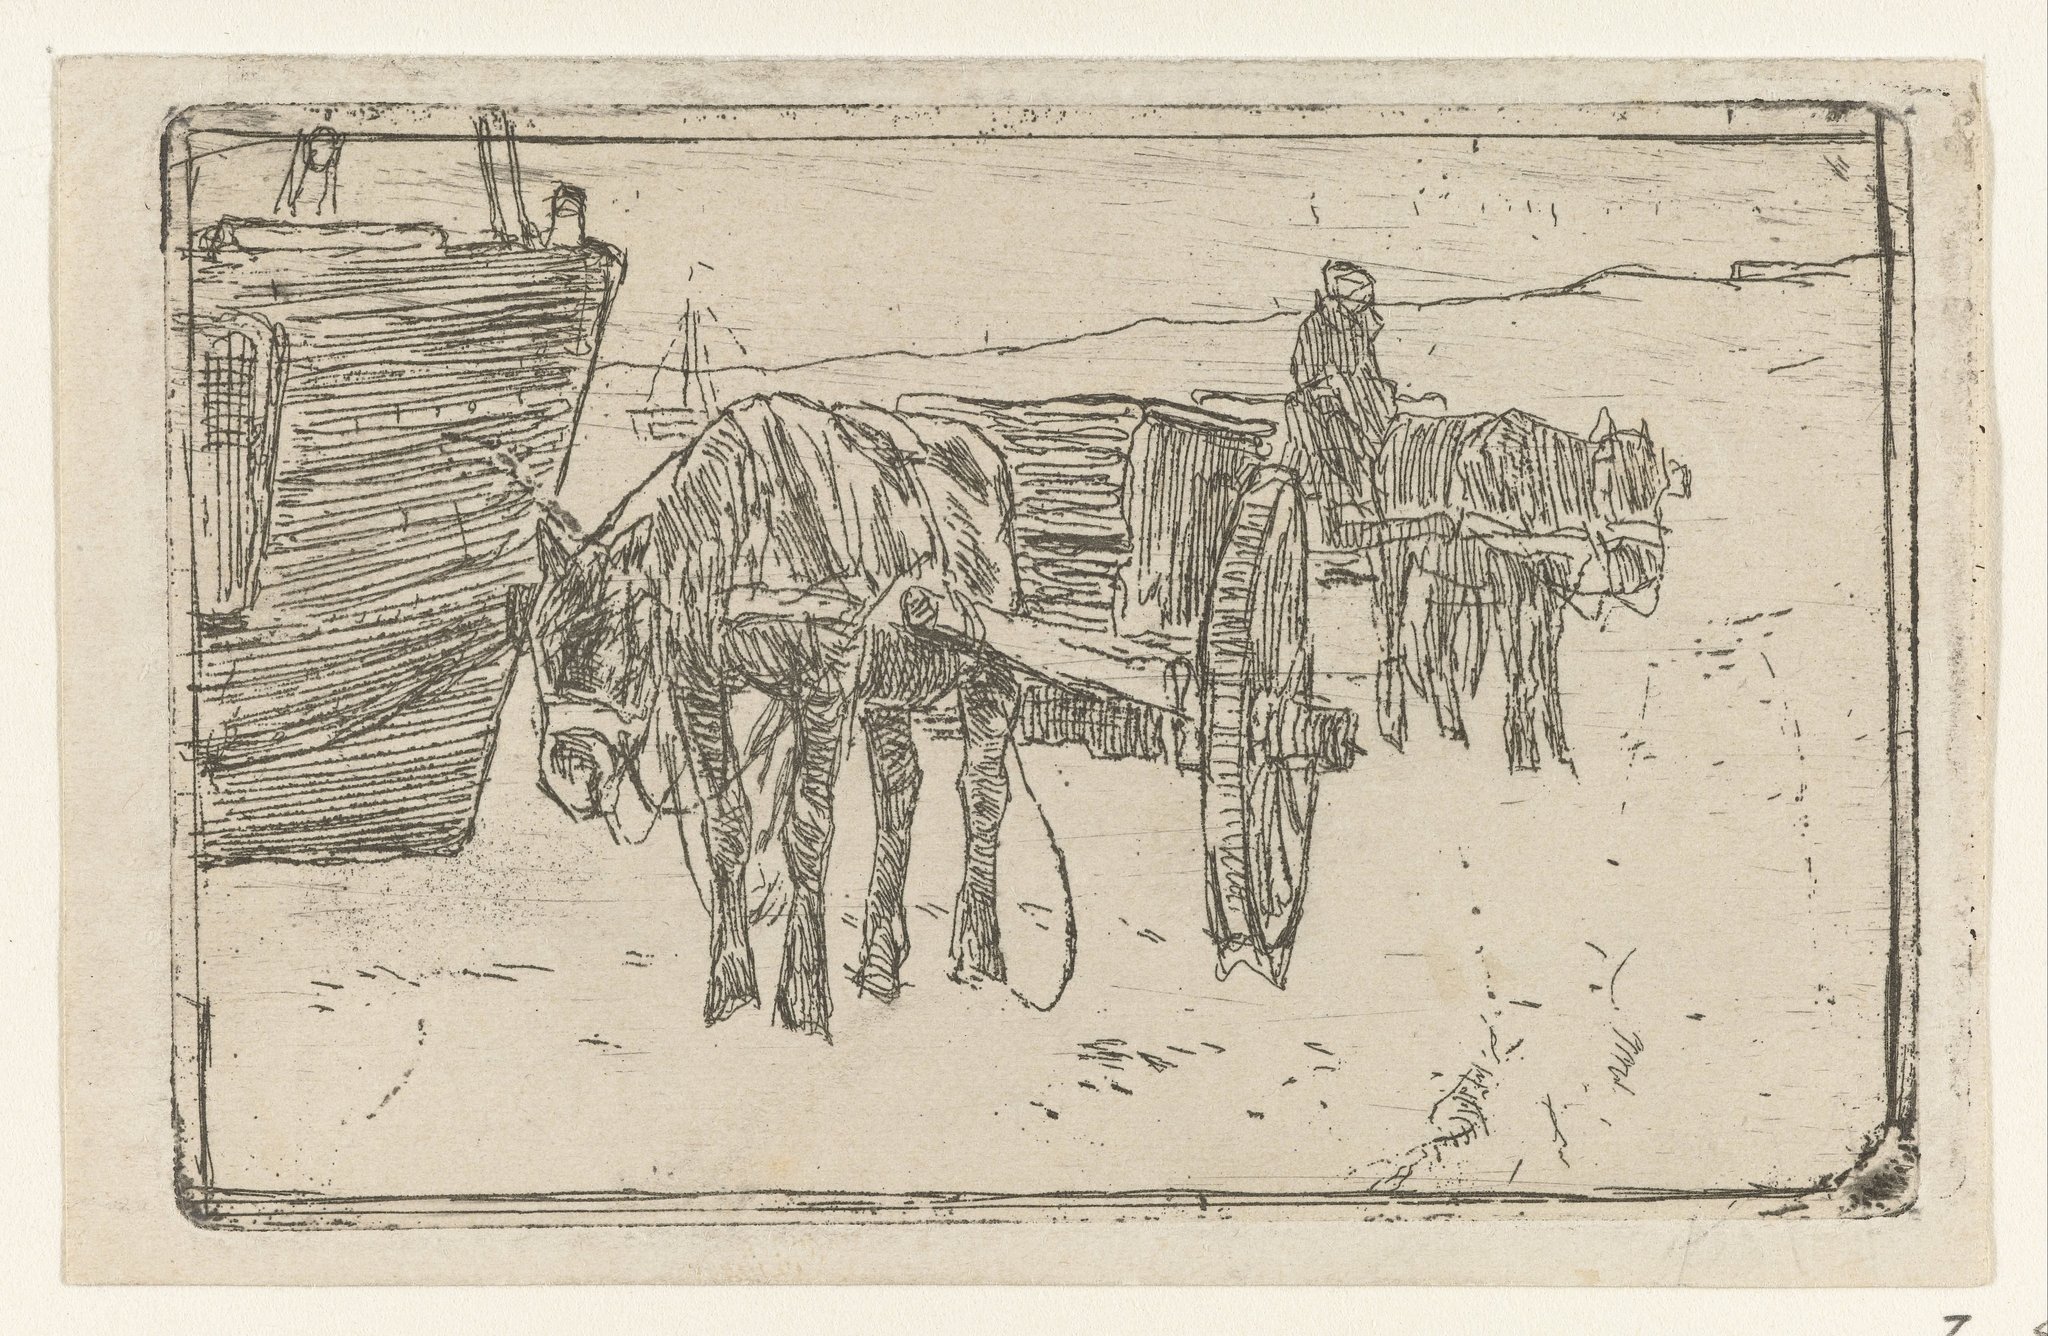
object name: print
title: Wagens op het strand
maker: anton mauve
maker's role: draughtsman, painter, print maker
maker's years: 1838-1888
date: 1848-1888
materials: paper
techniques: etching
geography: netherlands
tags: horse, two-wheeled vehicle drawn by one animal, beach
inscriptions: collector's mark: Lugt 2625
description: Paard en wagen op het strand met links het achtersteven van een schip. Op de achtergrond een paard en wagen met een man op de bok.